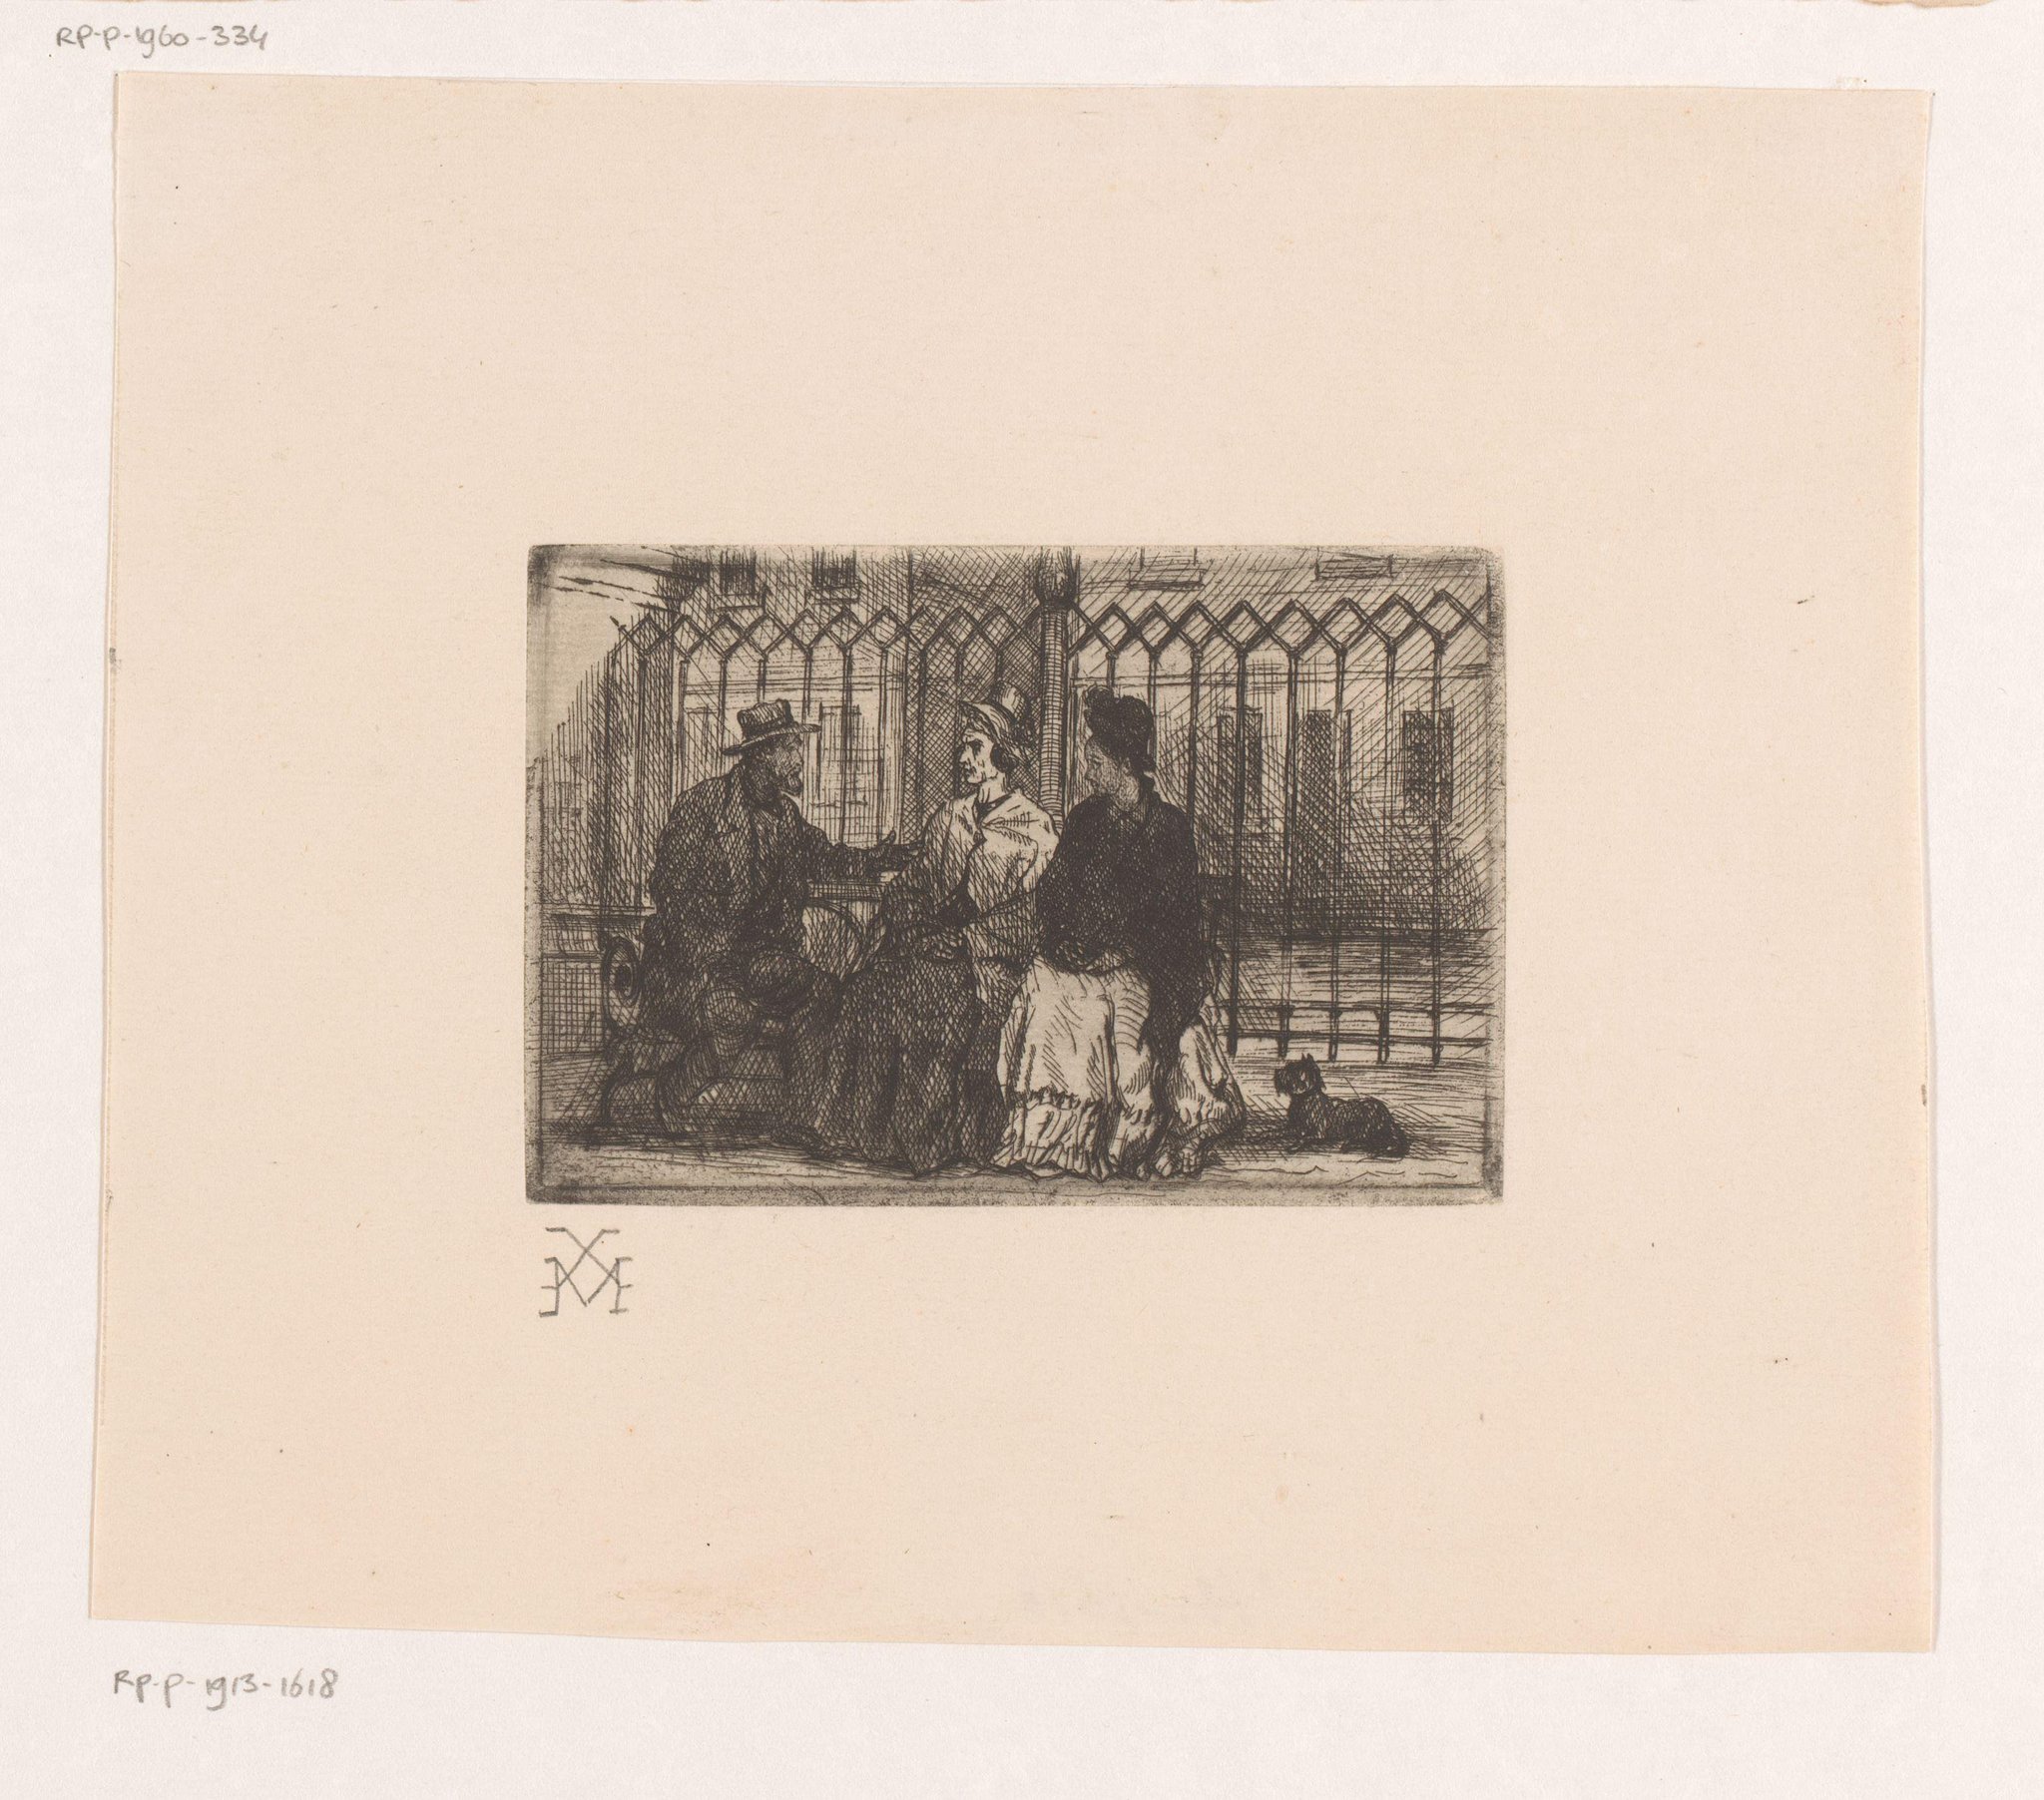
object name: print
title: Twee vrouwen en een man zittend op een bank voor een hek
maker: xavier mellery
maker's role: print maker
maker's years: 1845-1921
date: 1855-1913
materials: paper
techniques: etching, intaglio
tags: annexes and outbuildings; fencing; gate, bench, adult man, adult woman (+ two persons), dog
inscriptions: collector's mark: Lugt 2228